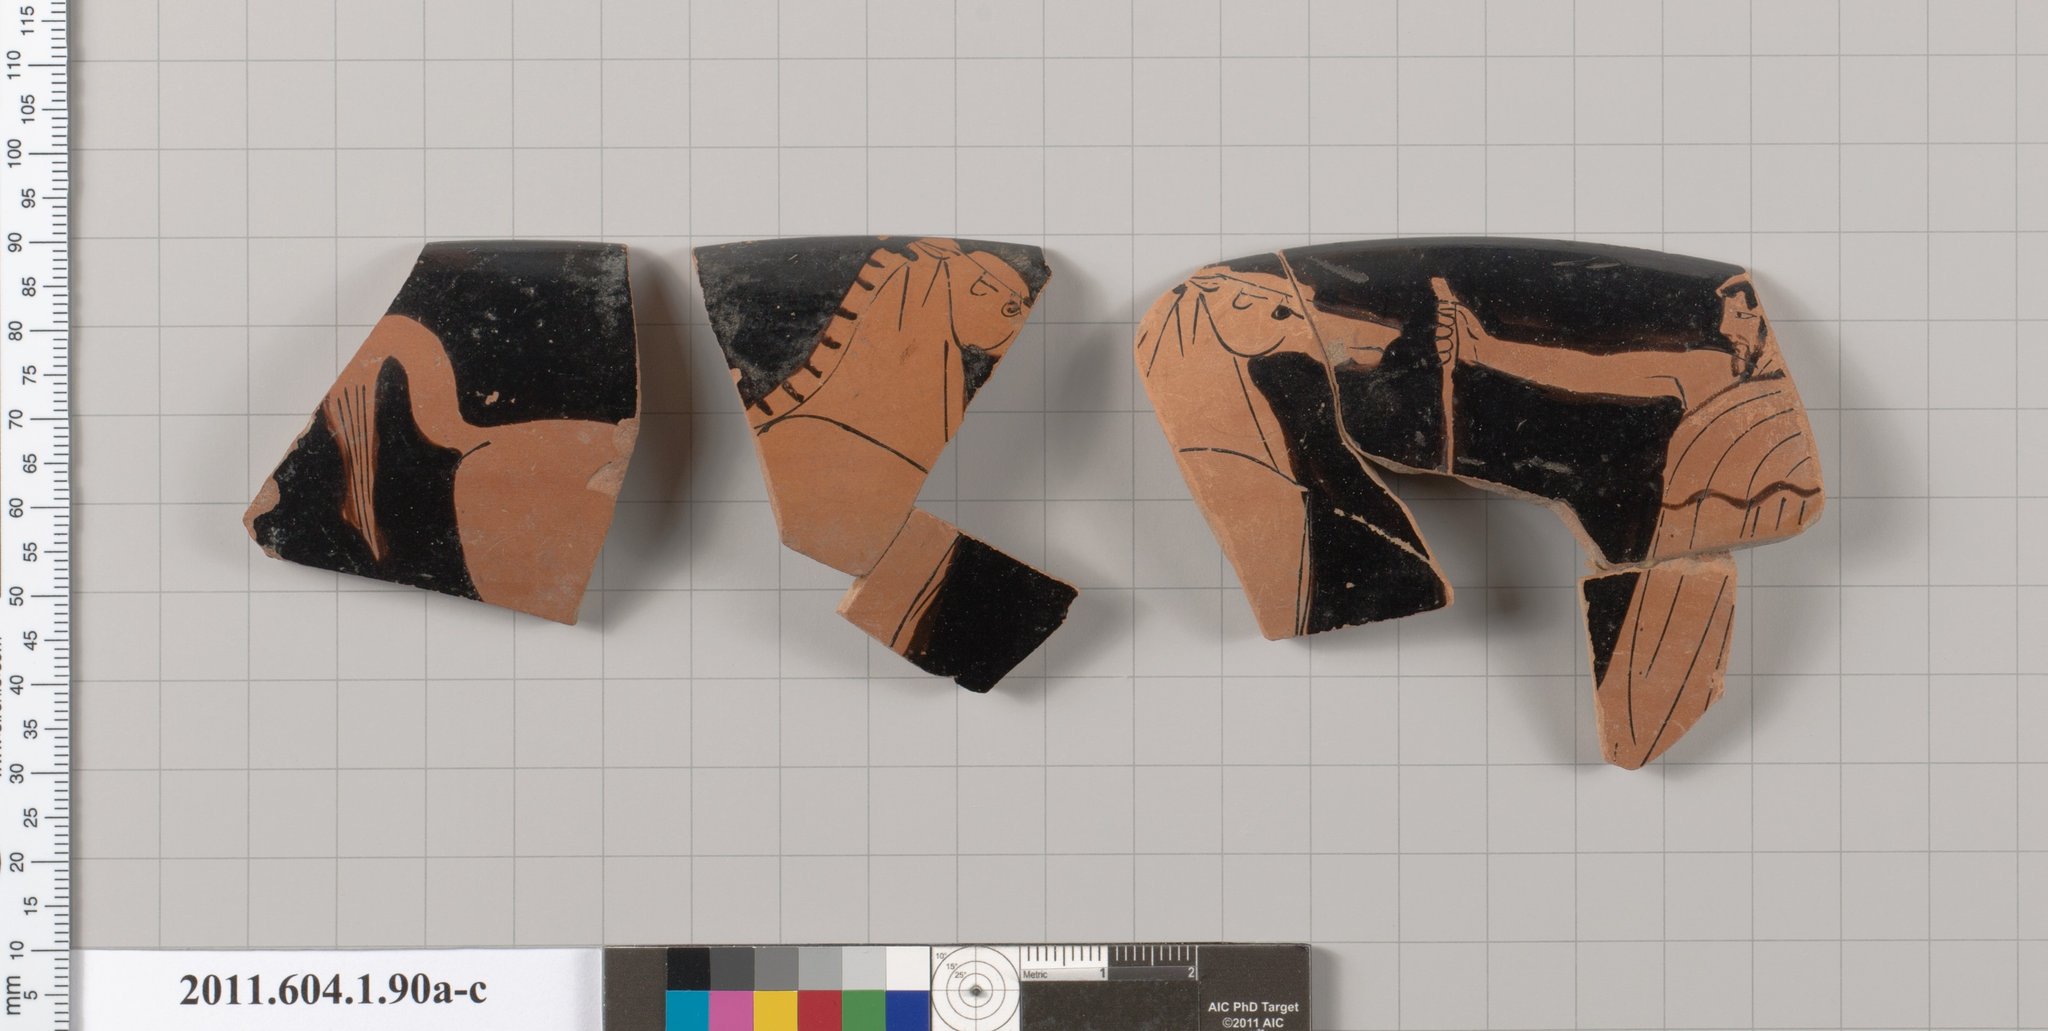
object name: kylix fragment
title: Terracotta rim fragments of a kylix (drinking cup)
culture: greek, attic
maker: painter of london d 12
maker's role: artist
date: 475-451 BCE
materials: terracotta